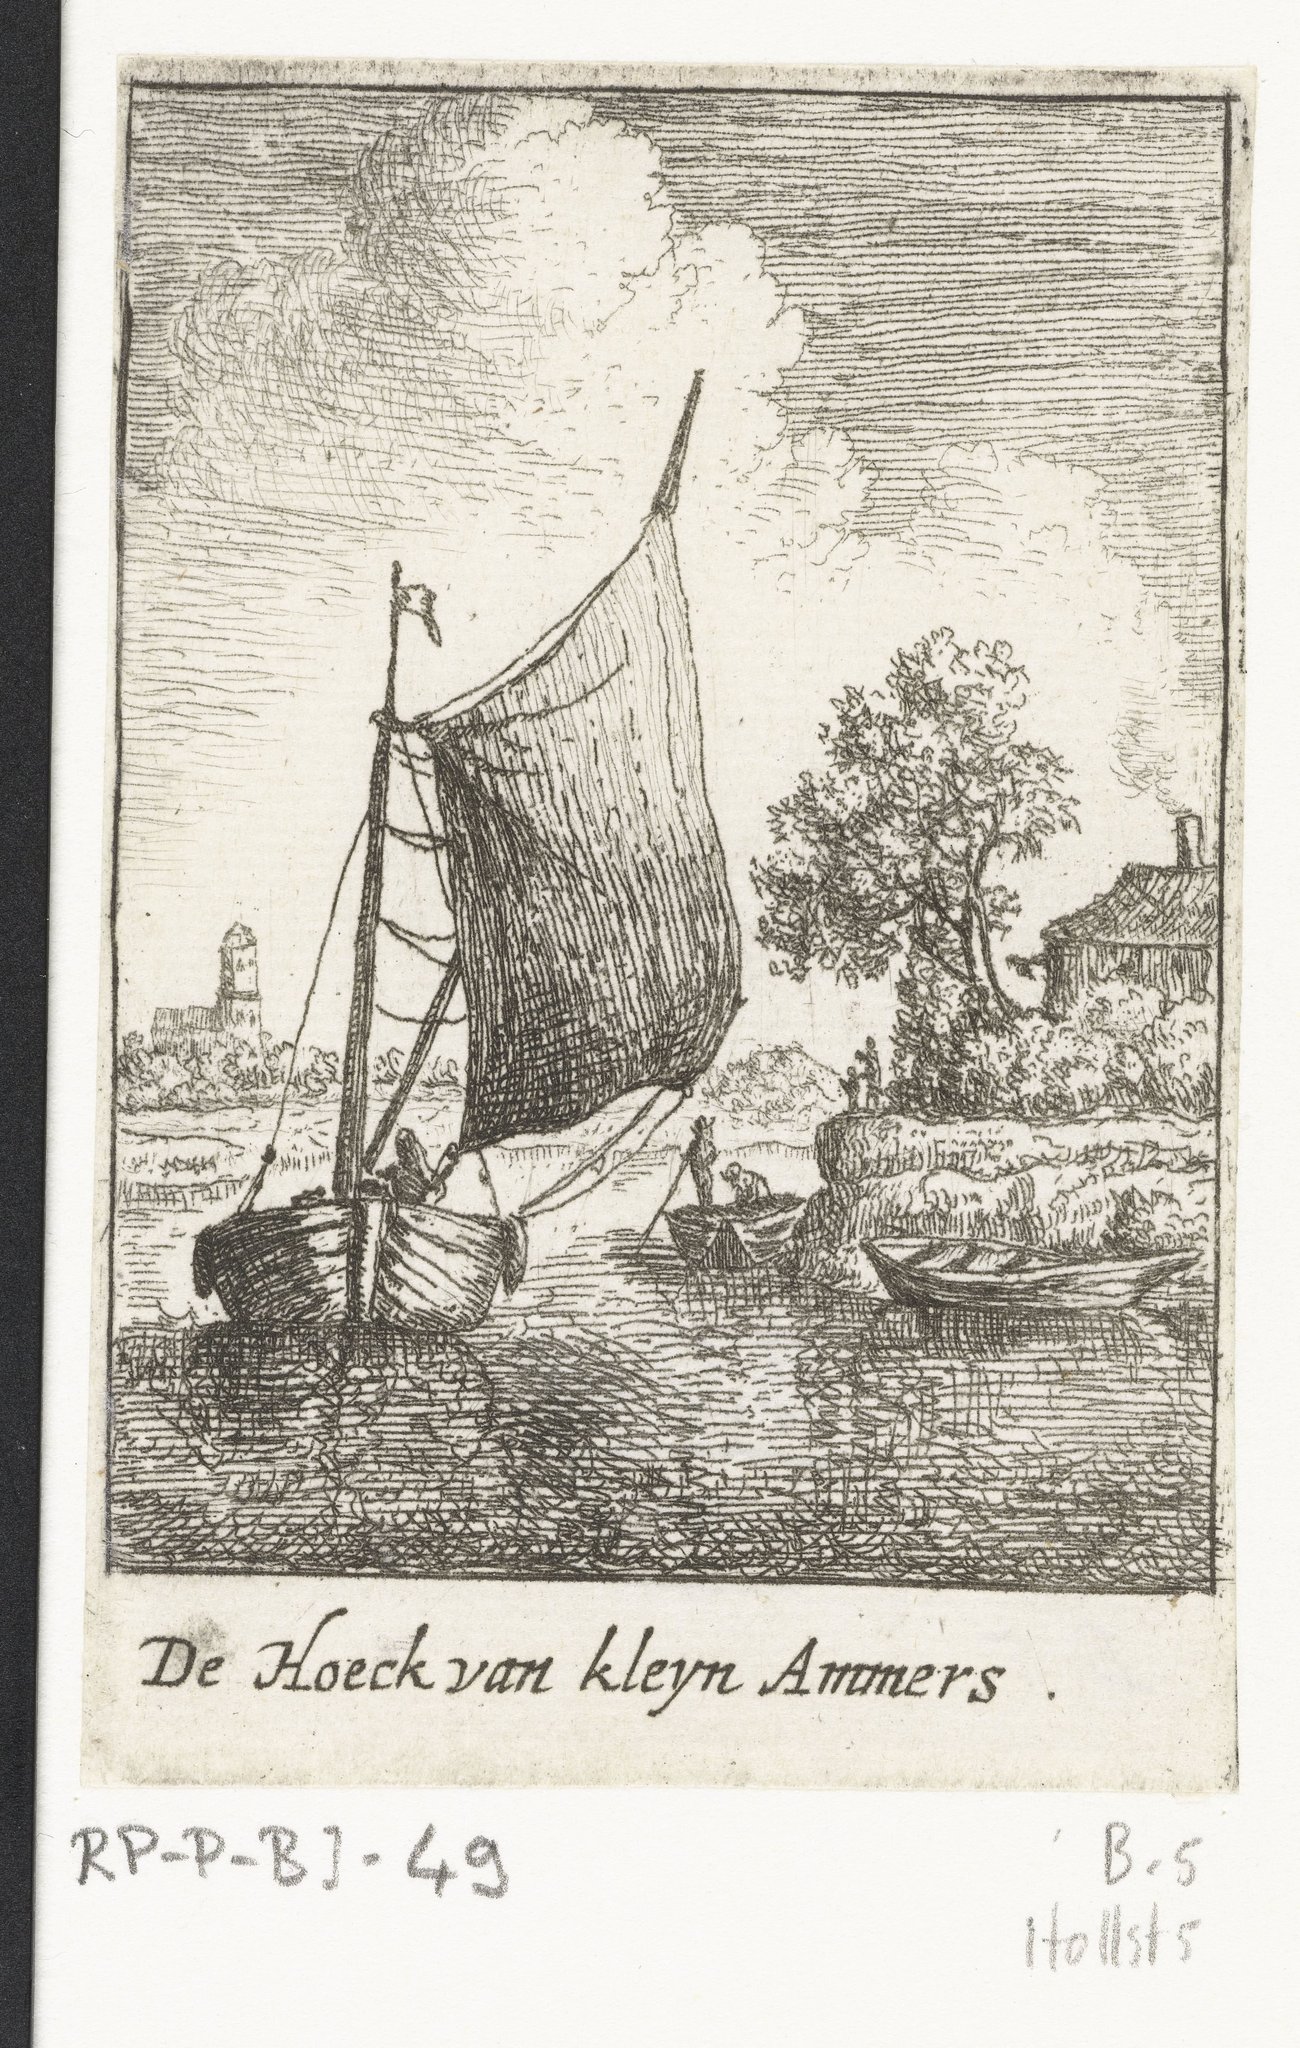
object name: print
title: Nederlandse dorpsgezichten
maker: jan van almeloveen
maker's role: draughtsman, print maker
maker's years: 1652-1683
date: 1662-1683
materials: paper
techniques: etching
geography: netherlands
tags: village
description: Gezicht op Ammerstol vanuit het water. Prent uit een serie van twaalf dorpsgezichten van Nederlandse plaatsen in de buurt van Utrecht met boten op de voorgrond.